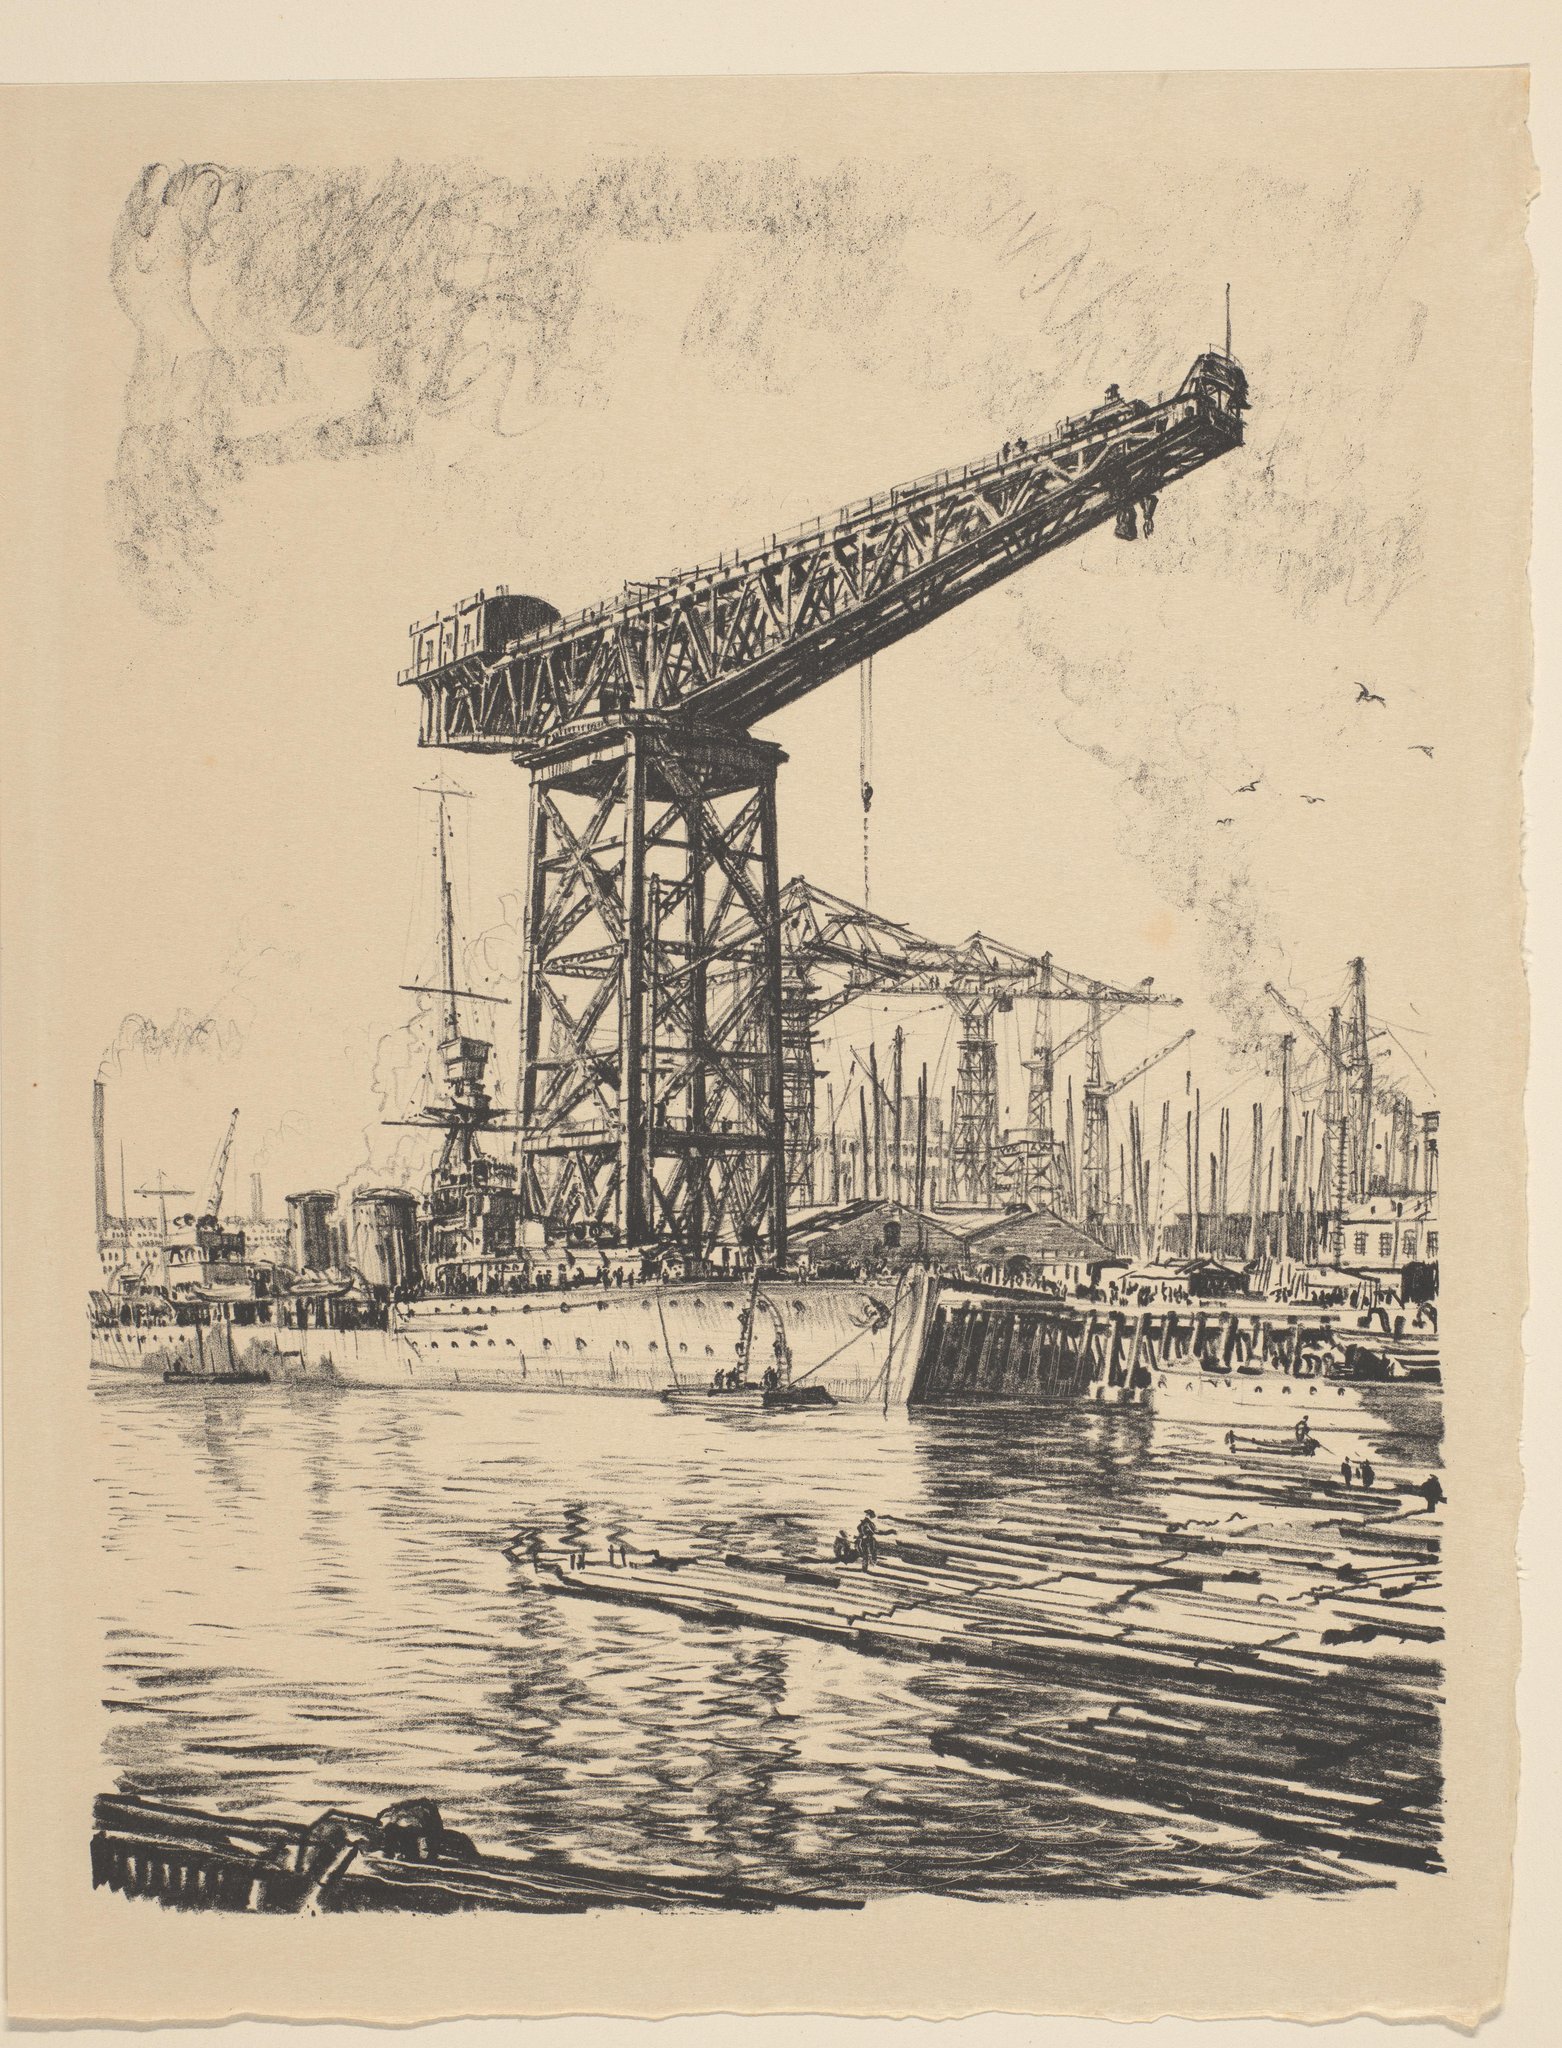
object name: print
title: Uitrustingsbassin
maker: muirhead bone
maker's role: artist, print maker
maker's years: 1876-1953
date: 1916-1917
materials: paper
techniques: lithograph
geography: england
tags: ships (in general), harbour equipment, building-site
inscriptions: watermark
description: Deze prent behoort tot de reeks 'Building Ships' binnen de serie 'The Great War: Britain’s Efforts and Ideals'.